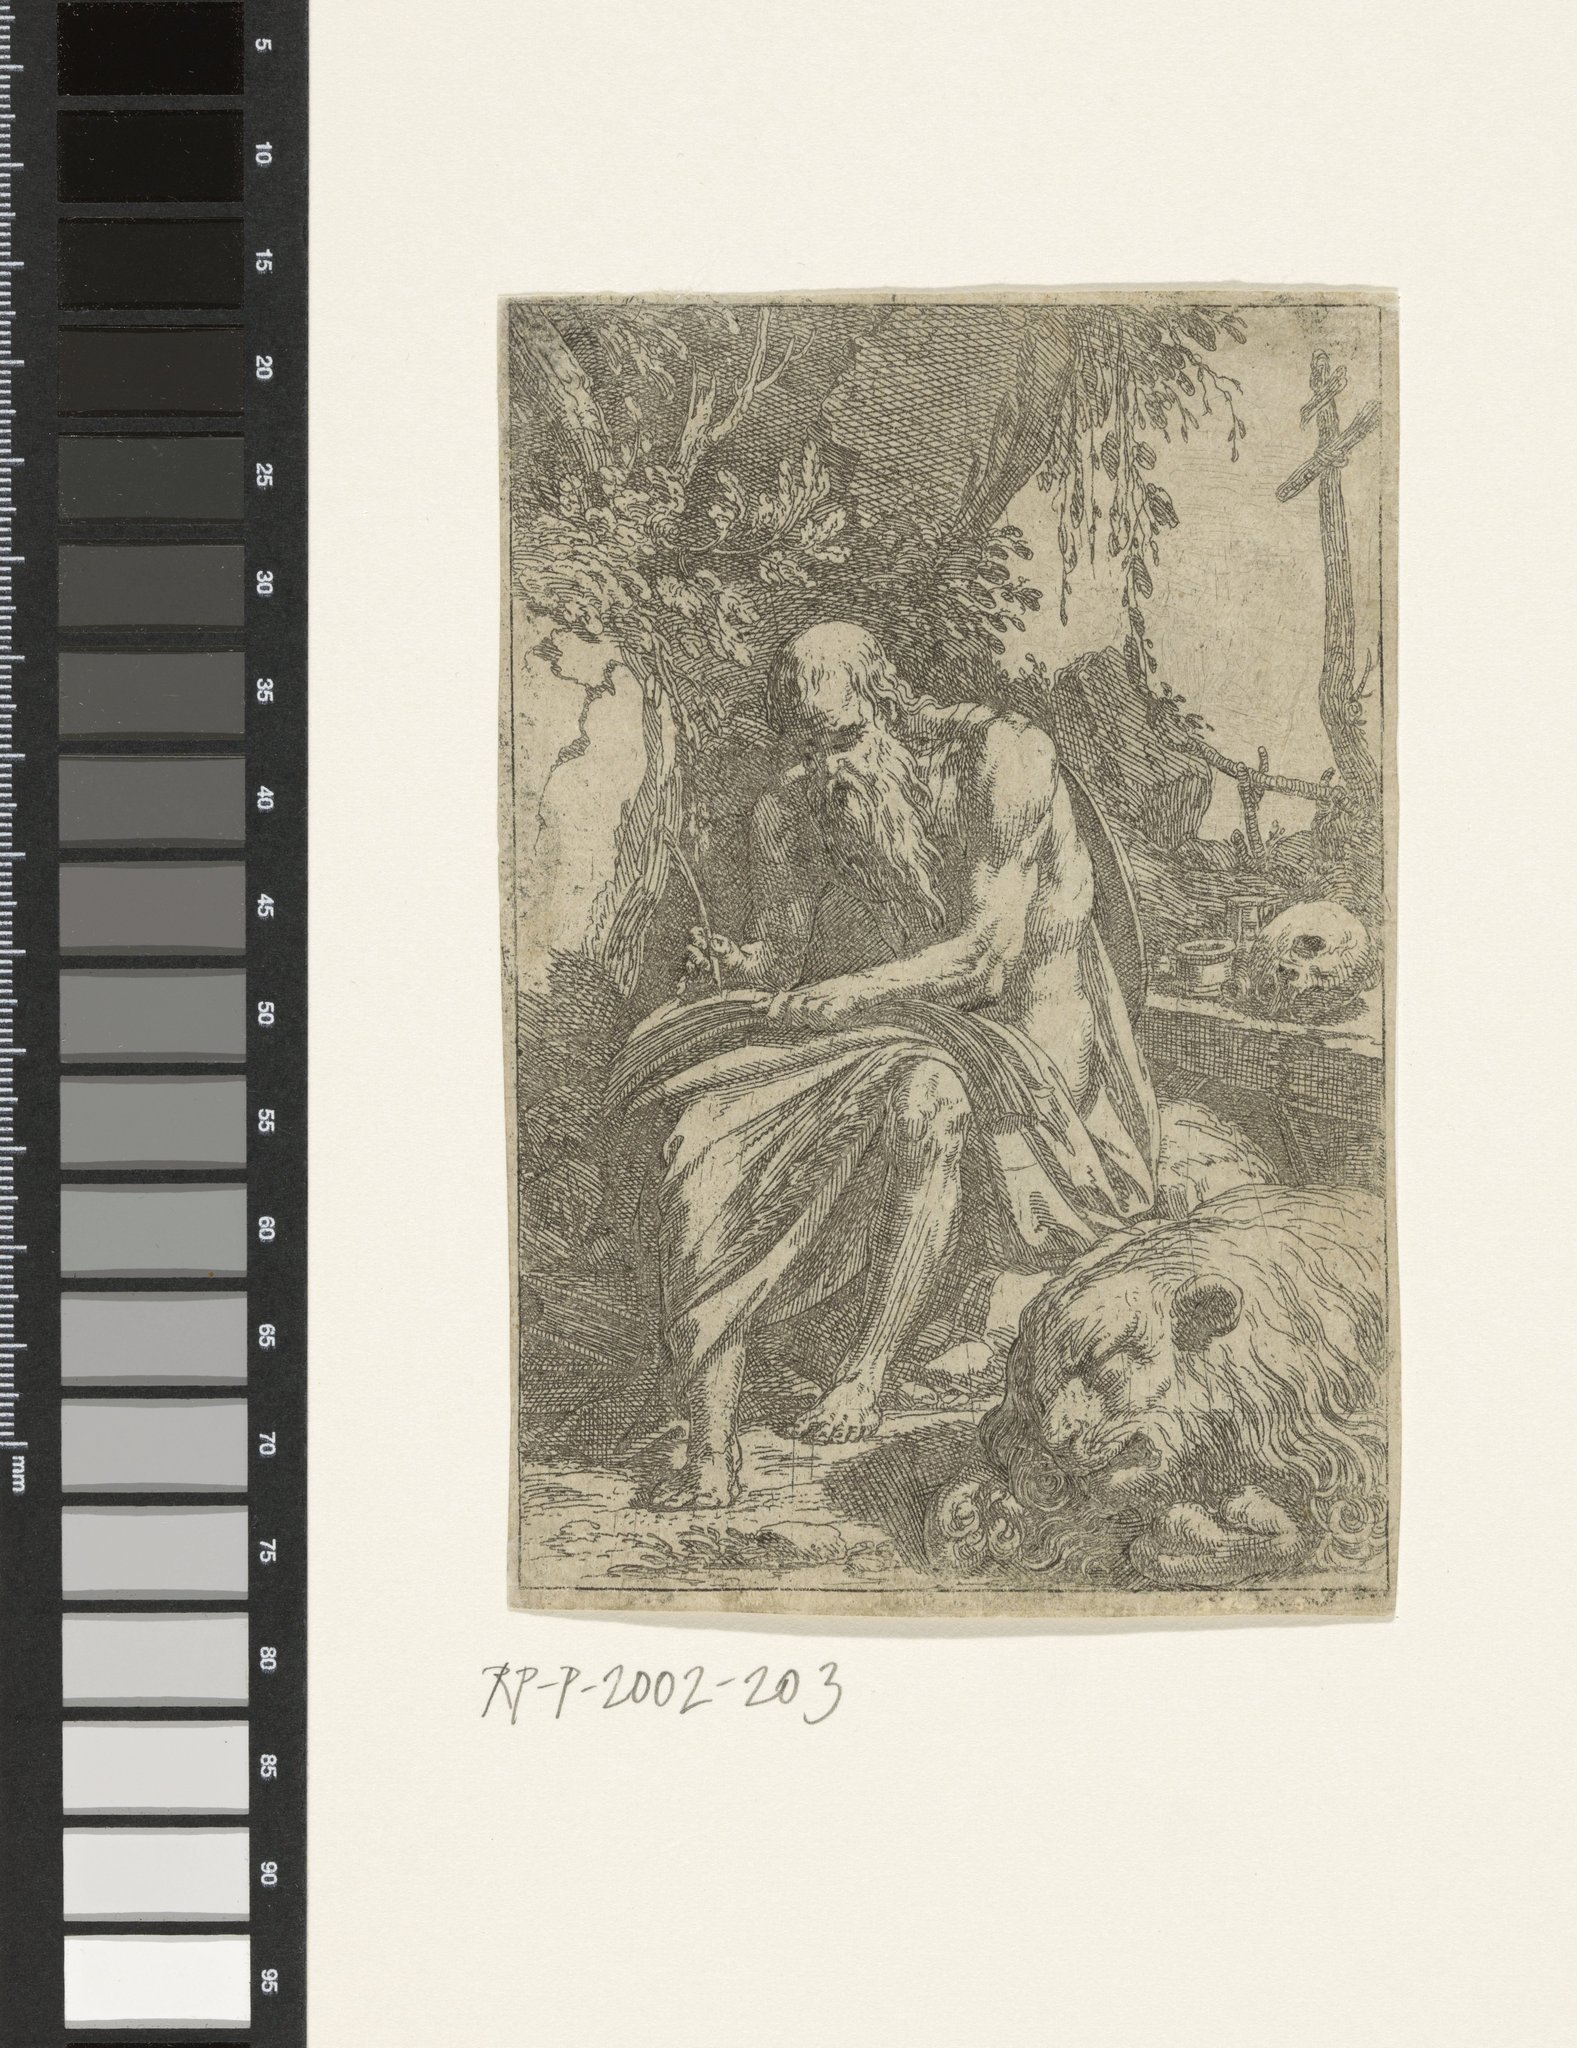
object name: print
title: Hieronymus in de wildernis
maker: giovanni battista fontana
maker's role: draughtsman, painter, print maker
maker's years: 1524-1587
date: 1534-1587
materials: paper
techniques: etching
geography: italy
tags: the monk and hermit jerome (hieronymus); possible attributes: book, cardinal's hat, crucifix, hour-glass, lion, skull, stone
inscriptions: collector's mark: Lugt 2228, collector's mark: Lugt 2760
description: De heilige Hieronymus zit te schrijven. Naast hem ligt de leeuw. Rechtsachter een kruis, zandloper en schedel.